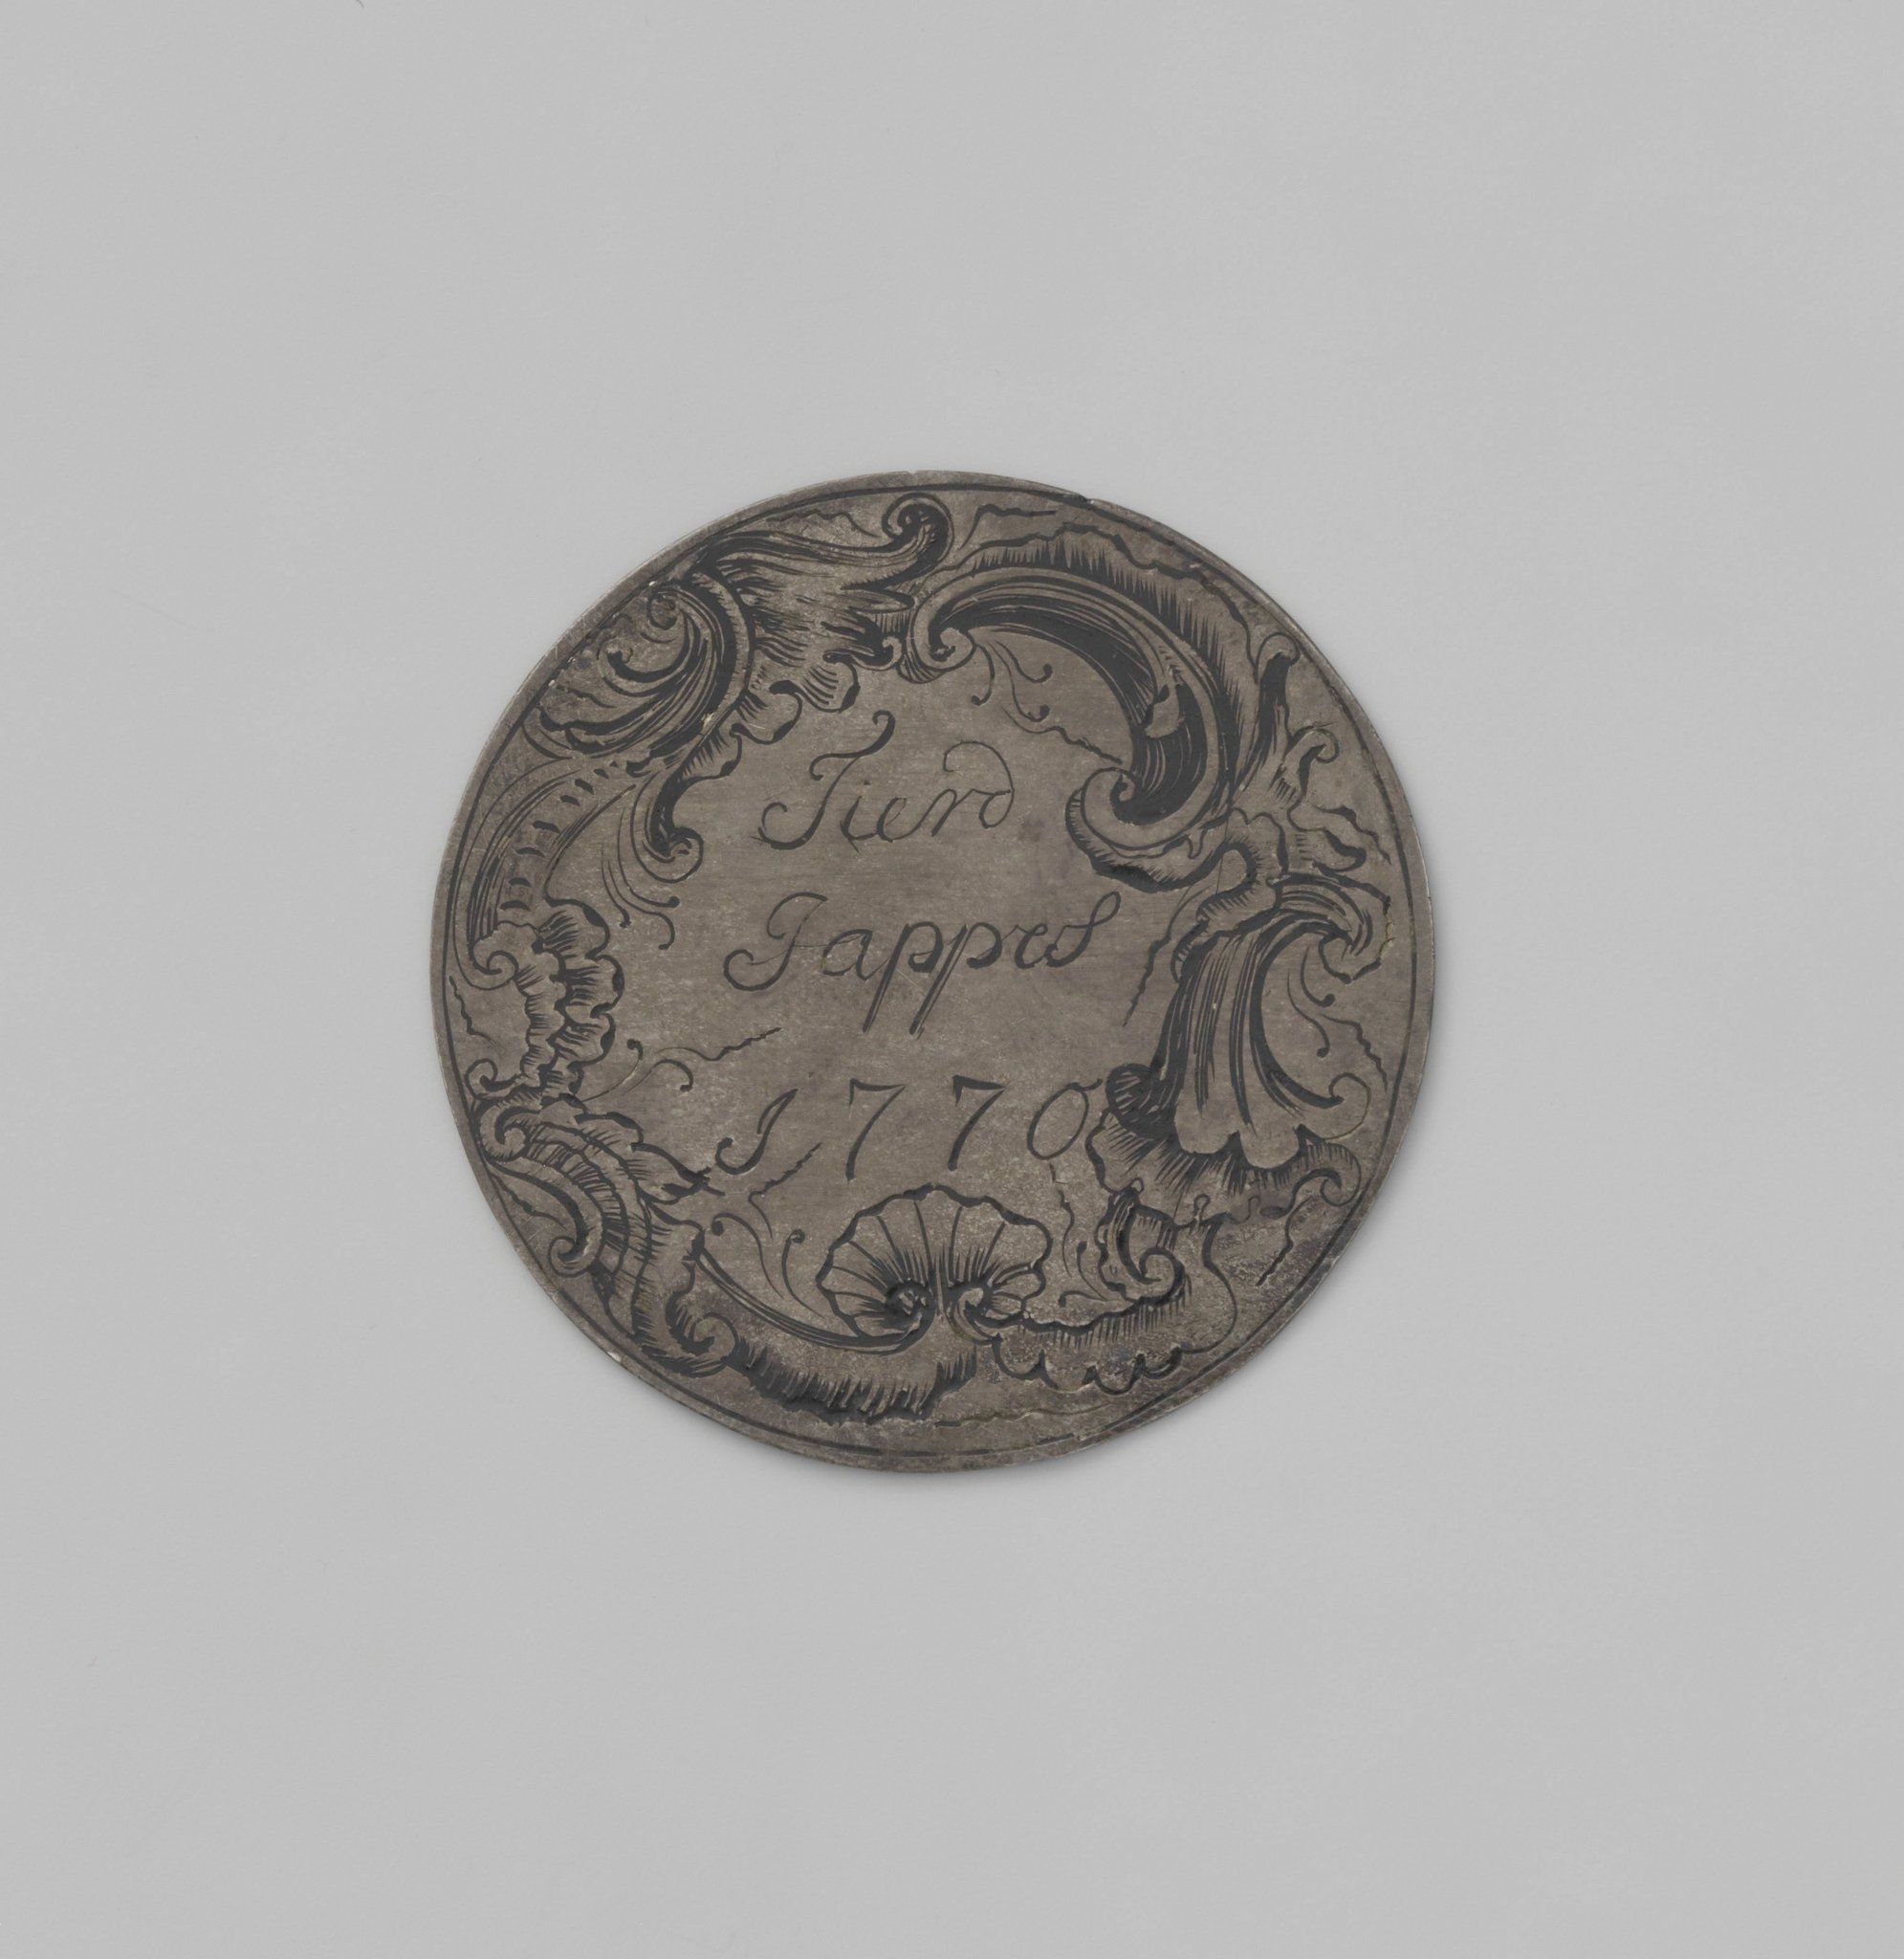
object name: medal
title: Bakers, Enkhuizen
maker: Anonymous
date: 1770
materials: silver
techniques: engraving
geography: enkhuizen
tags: enkhuizen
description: Guild medals Members of trade guilds had to identify themselves with a medal at their meetings.